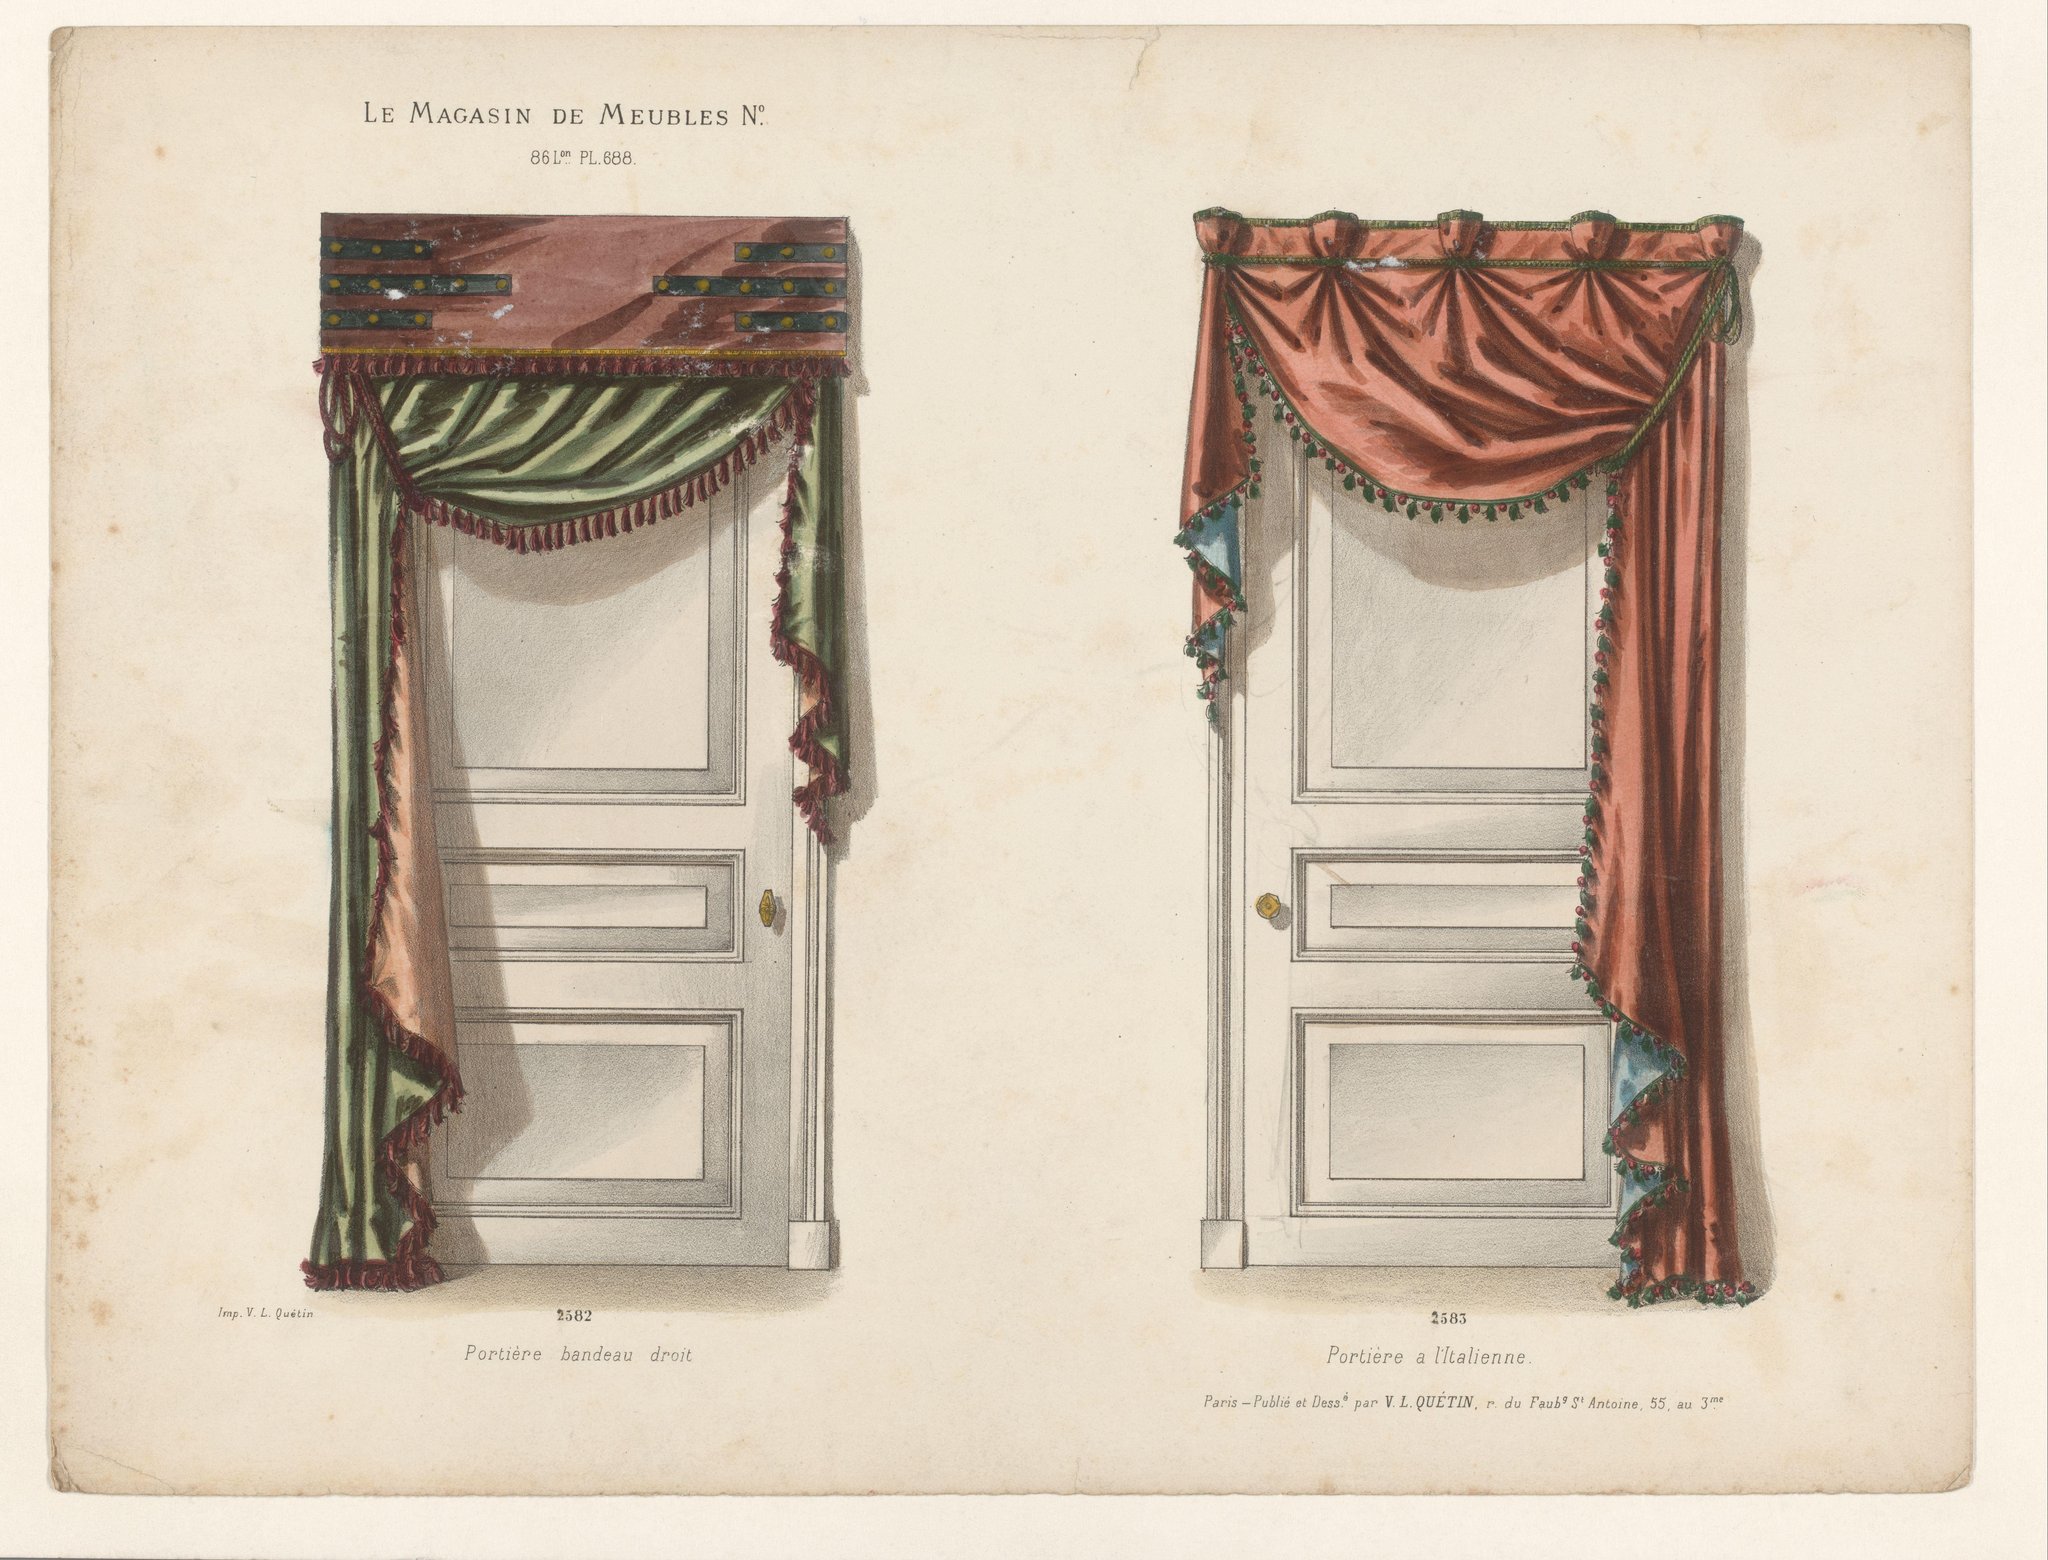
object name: print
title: Twee deuren met gordijnen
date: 1878-1904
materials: paper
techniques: hand coloring, lithograph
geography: paris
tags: door, hangings and drapery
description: Twee deuren met gedrapeerde gordijnen. Prent uit 86e Livraison.